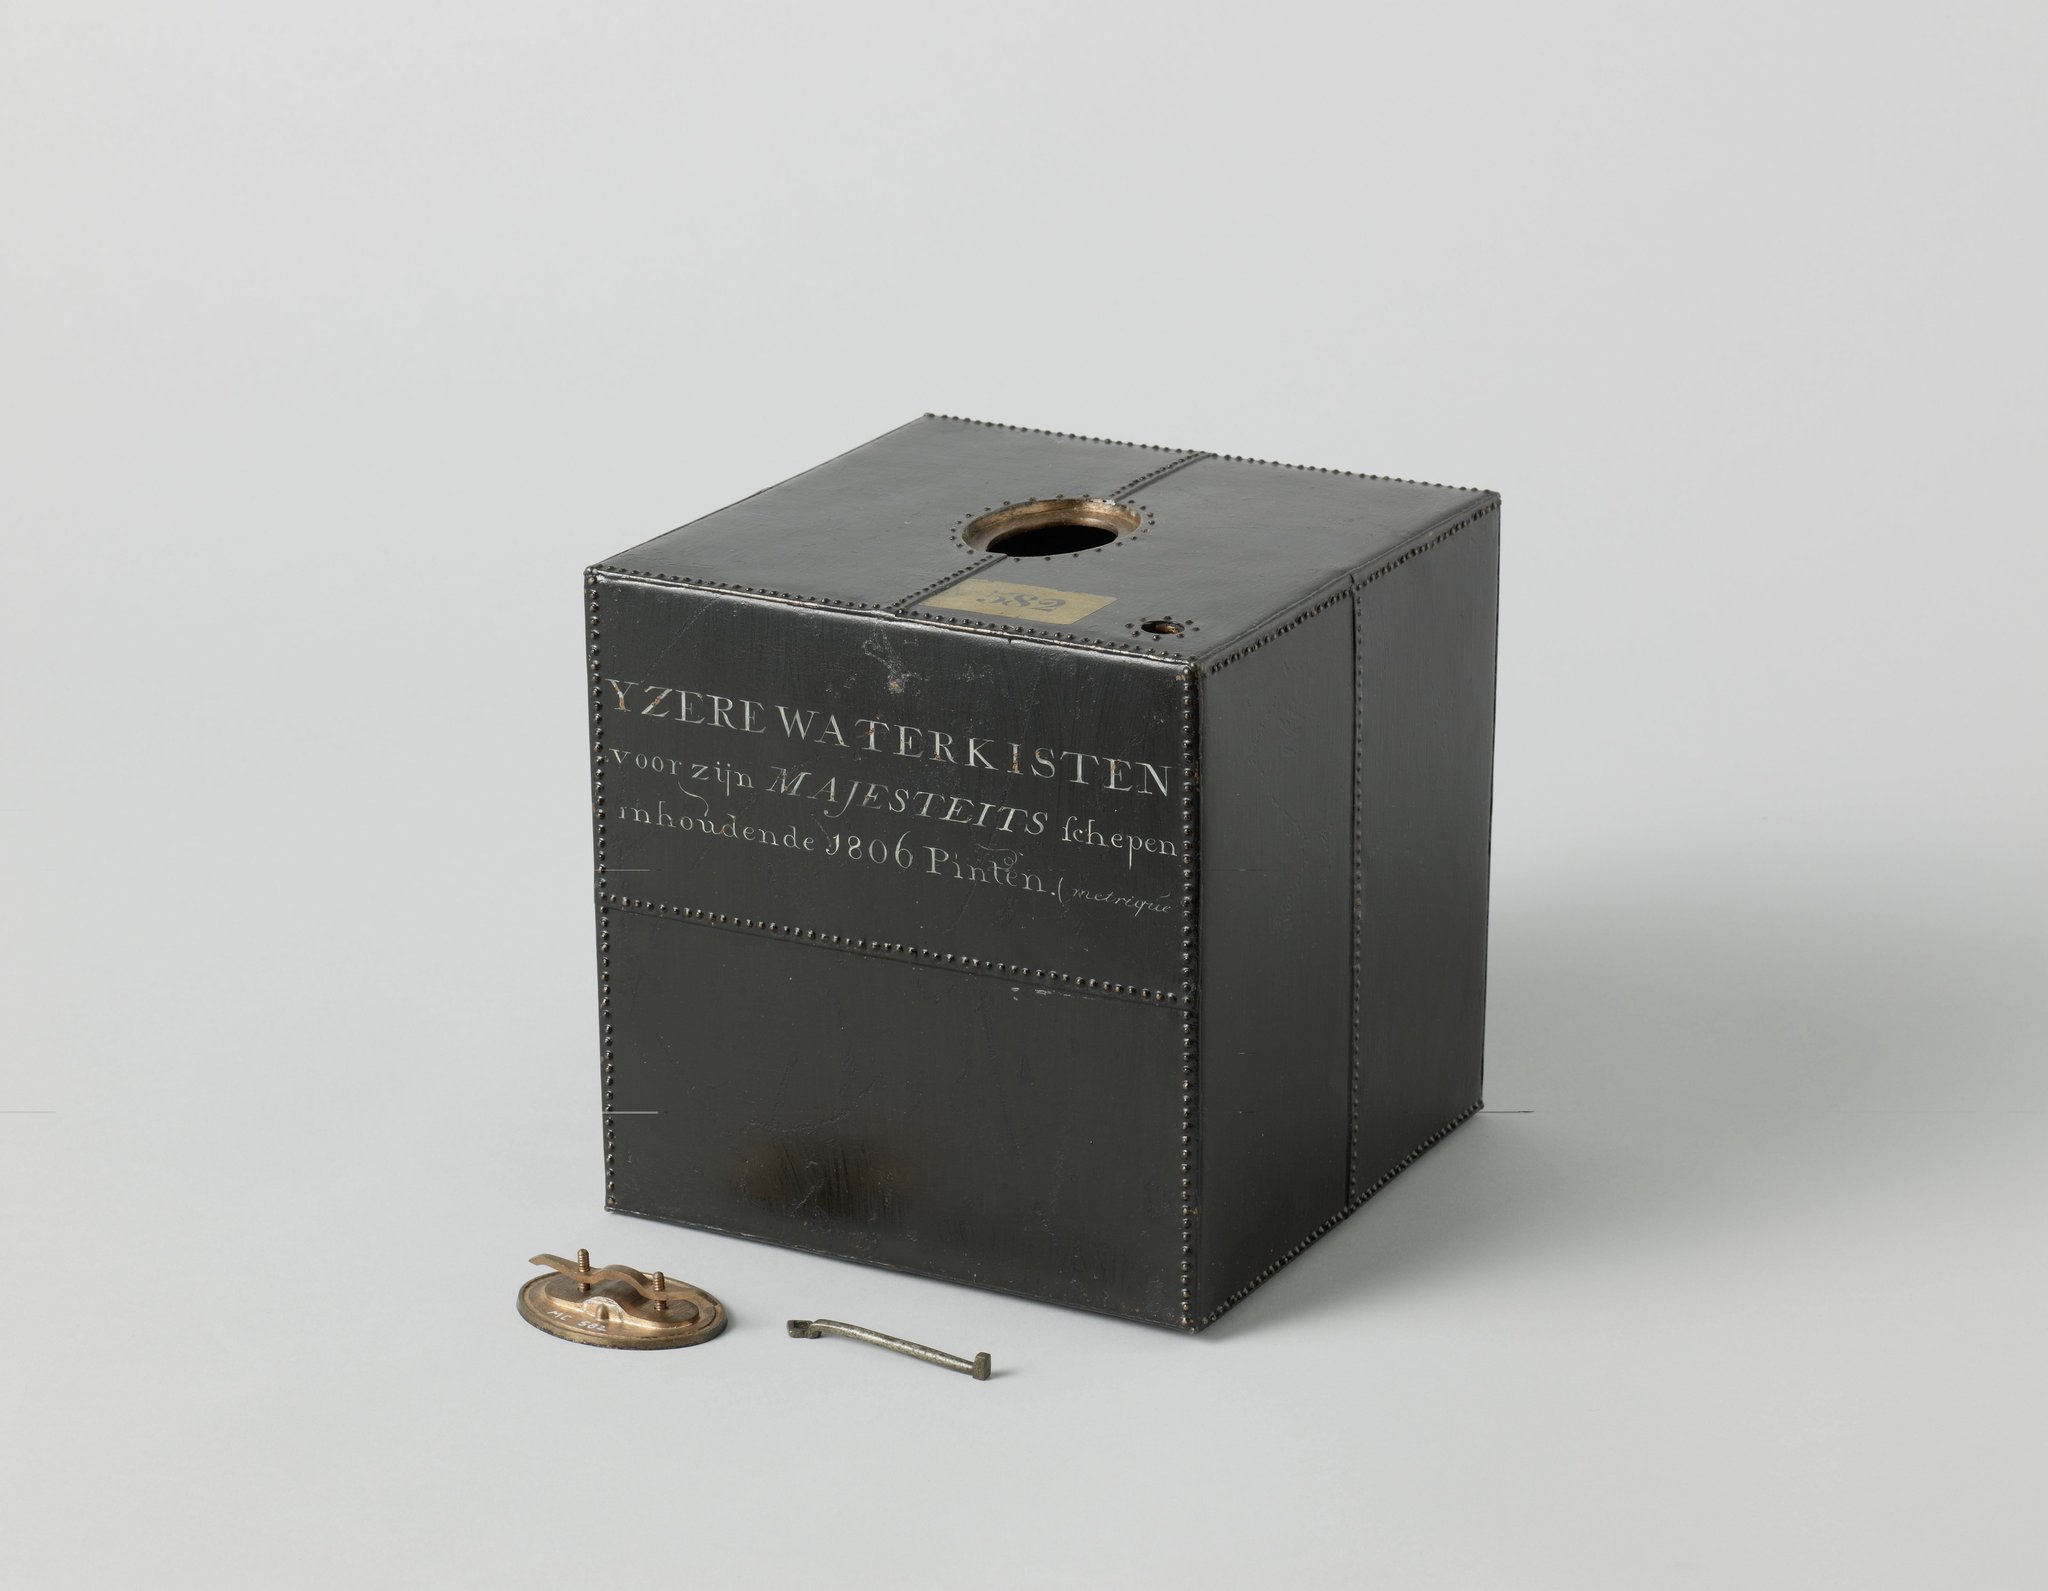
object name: instruction model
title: Model of a Water Tank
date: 1839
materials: copper, iron, paint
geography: hellevoetsluis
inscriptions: label, on the top: ‘582’ former inventory label, inscription, on the front: ‘YZERE WATERKISTEN, / voor zijn MAJESTEITS schepen / inhoudend 1806 Pinten. métrique.’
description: Model van een kubusvormige waterkist, zwart geverfd. Het is gemaakt van geklonken platen roodkoper. In de bovenzijde is een ovalen mangat met deksel aangebracht; bij een van de hoeken is een klein rond gat waardoor een lange sleutel neergelaten kan worden om een afsluiter in de bodem open te draaien. Een korte ijzeren sleutel waarmee het mangat en het gat voor de lange sleutel kunnen worden geopend, is aan het model toegevoegd. Schaal 1:20.